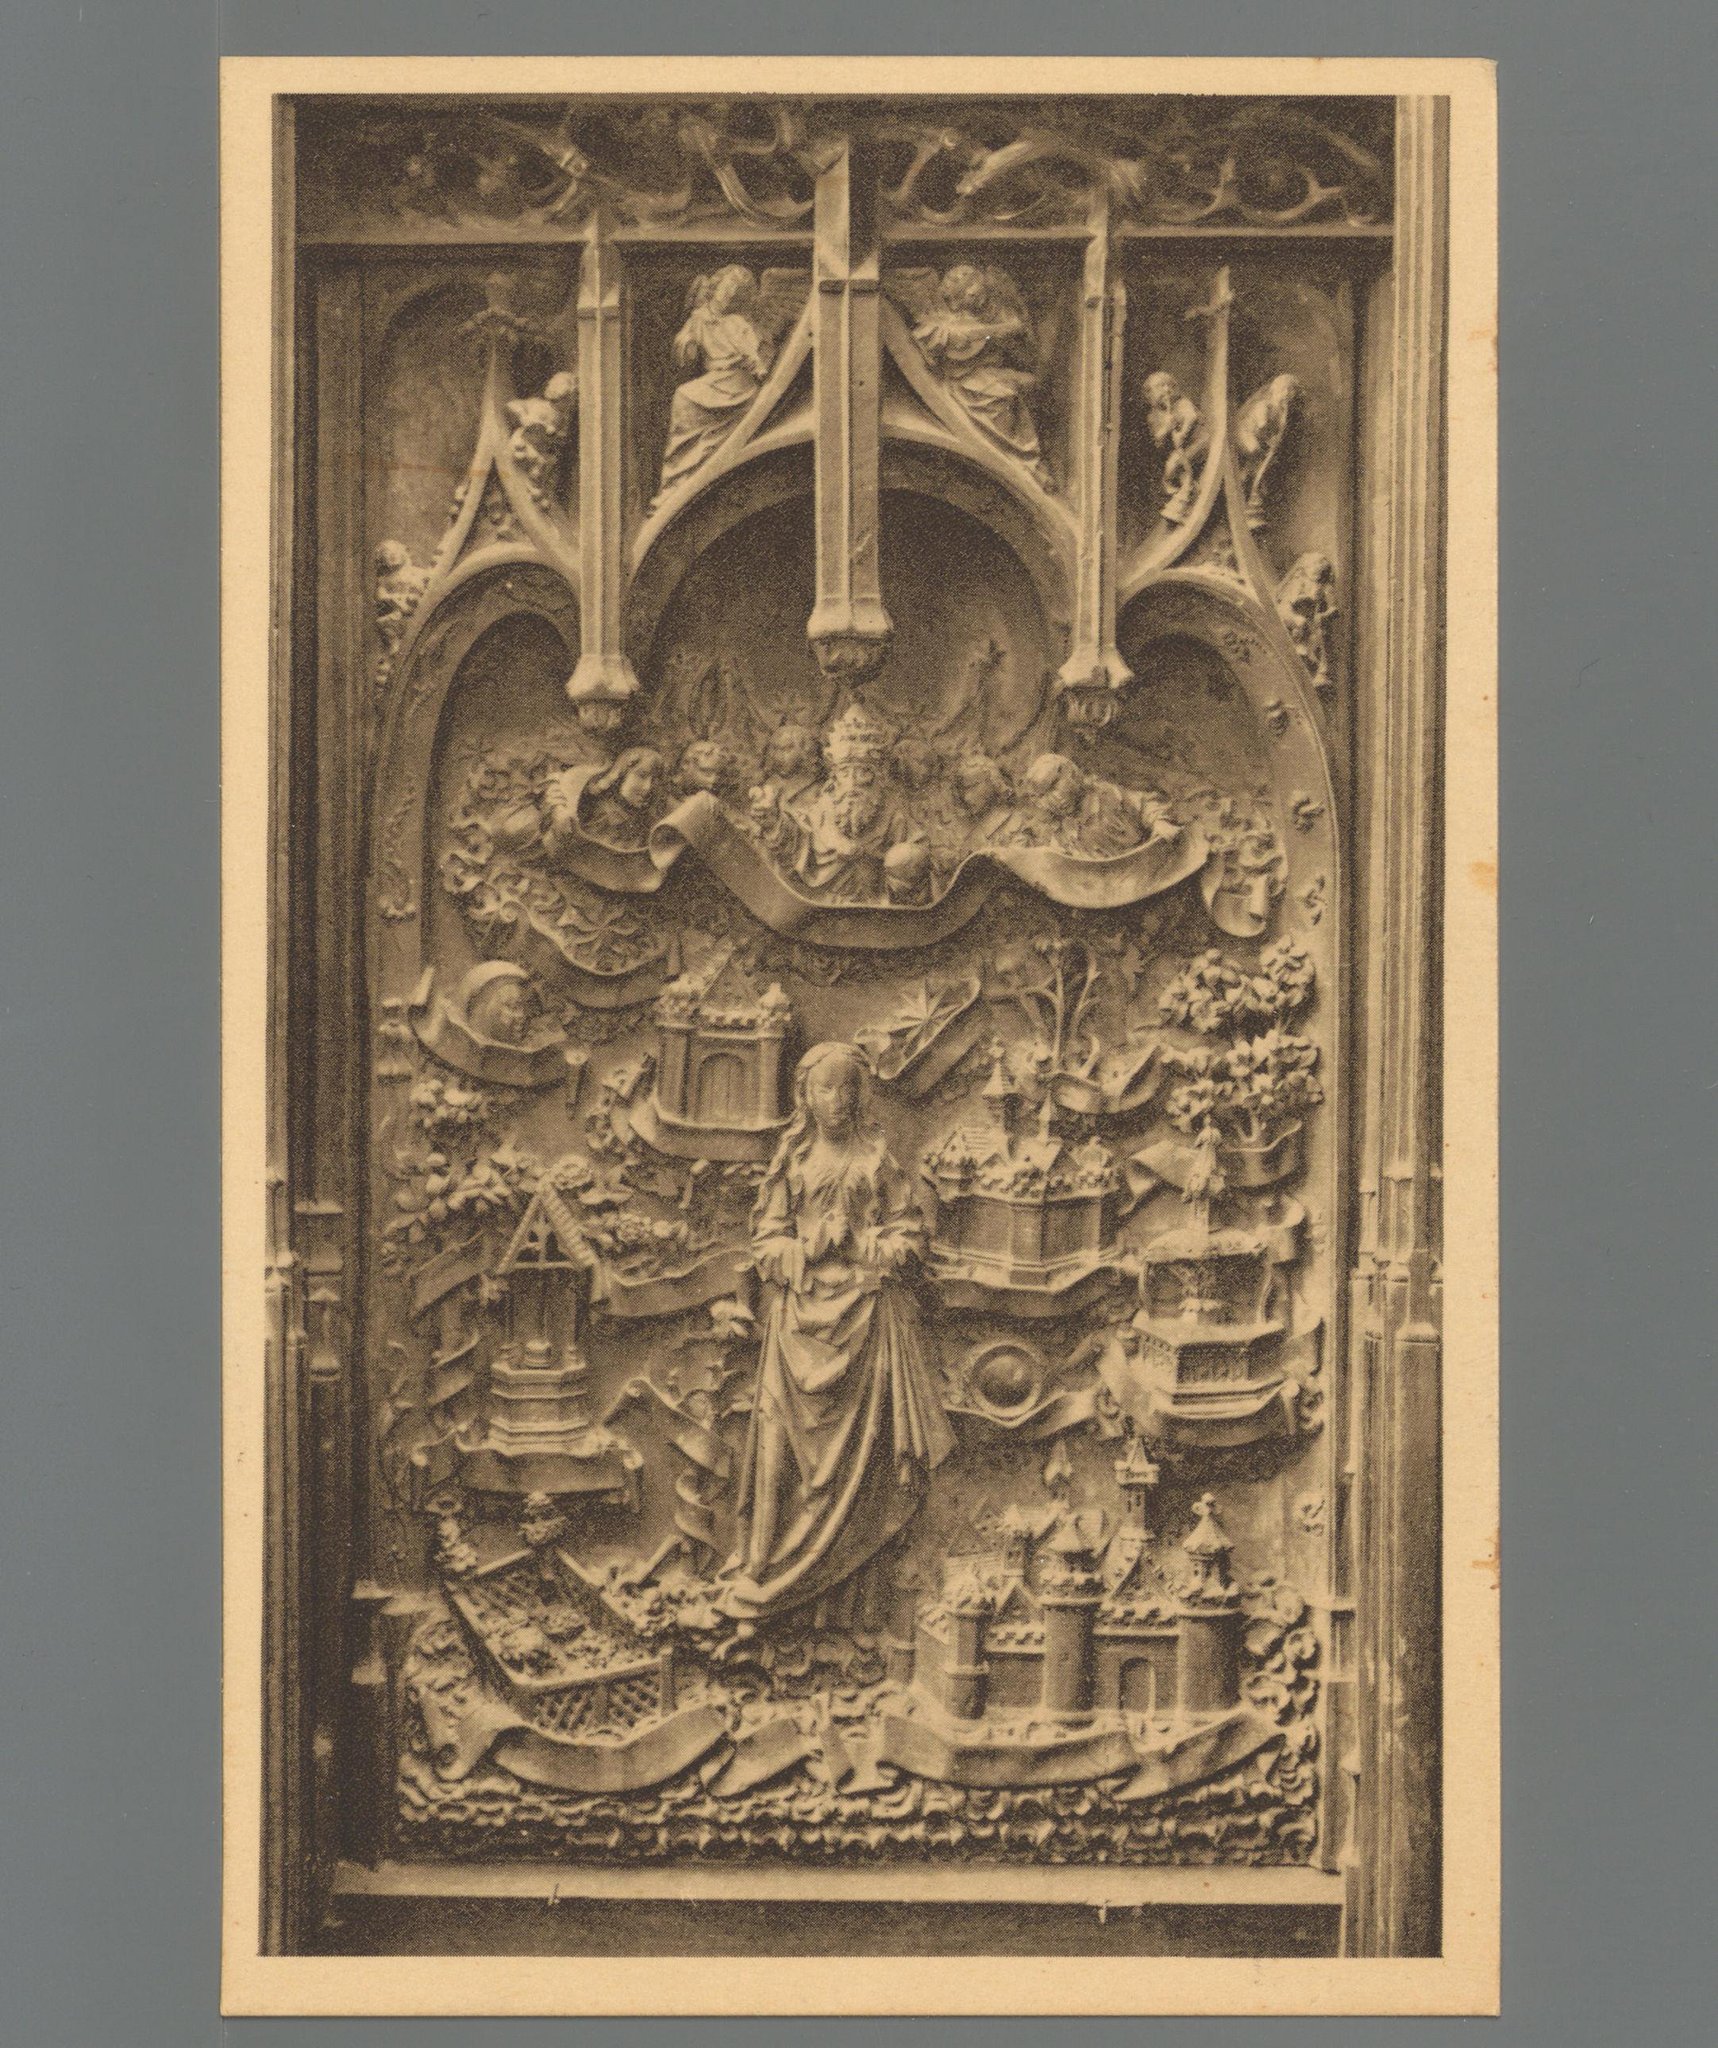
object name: ansichtkaart, prentbriefkaart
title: Cathédrale d'Amiens. Stalles du Choeur (XVIe siècle). Représentation symbolique de l'Immaculée Conception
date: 1903-1930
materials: cardboard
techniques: rotogravure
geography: amiens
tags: statues, paintings, etc. ~ objects of worship in roman religion, interior of church, notre-dame d'amiens